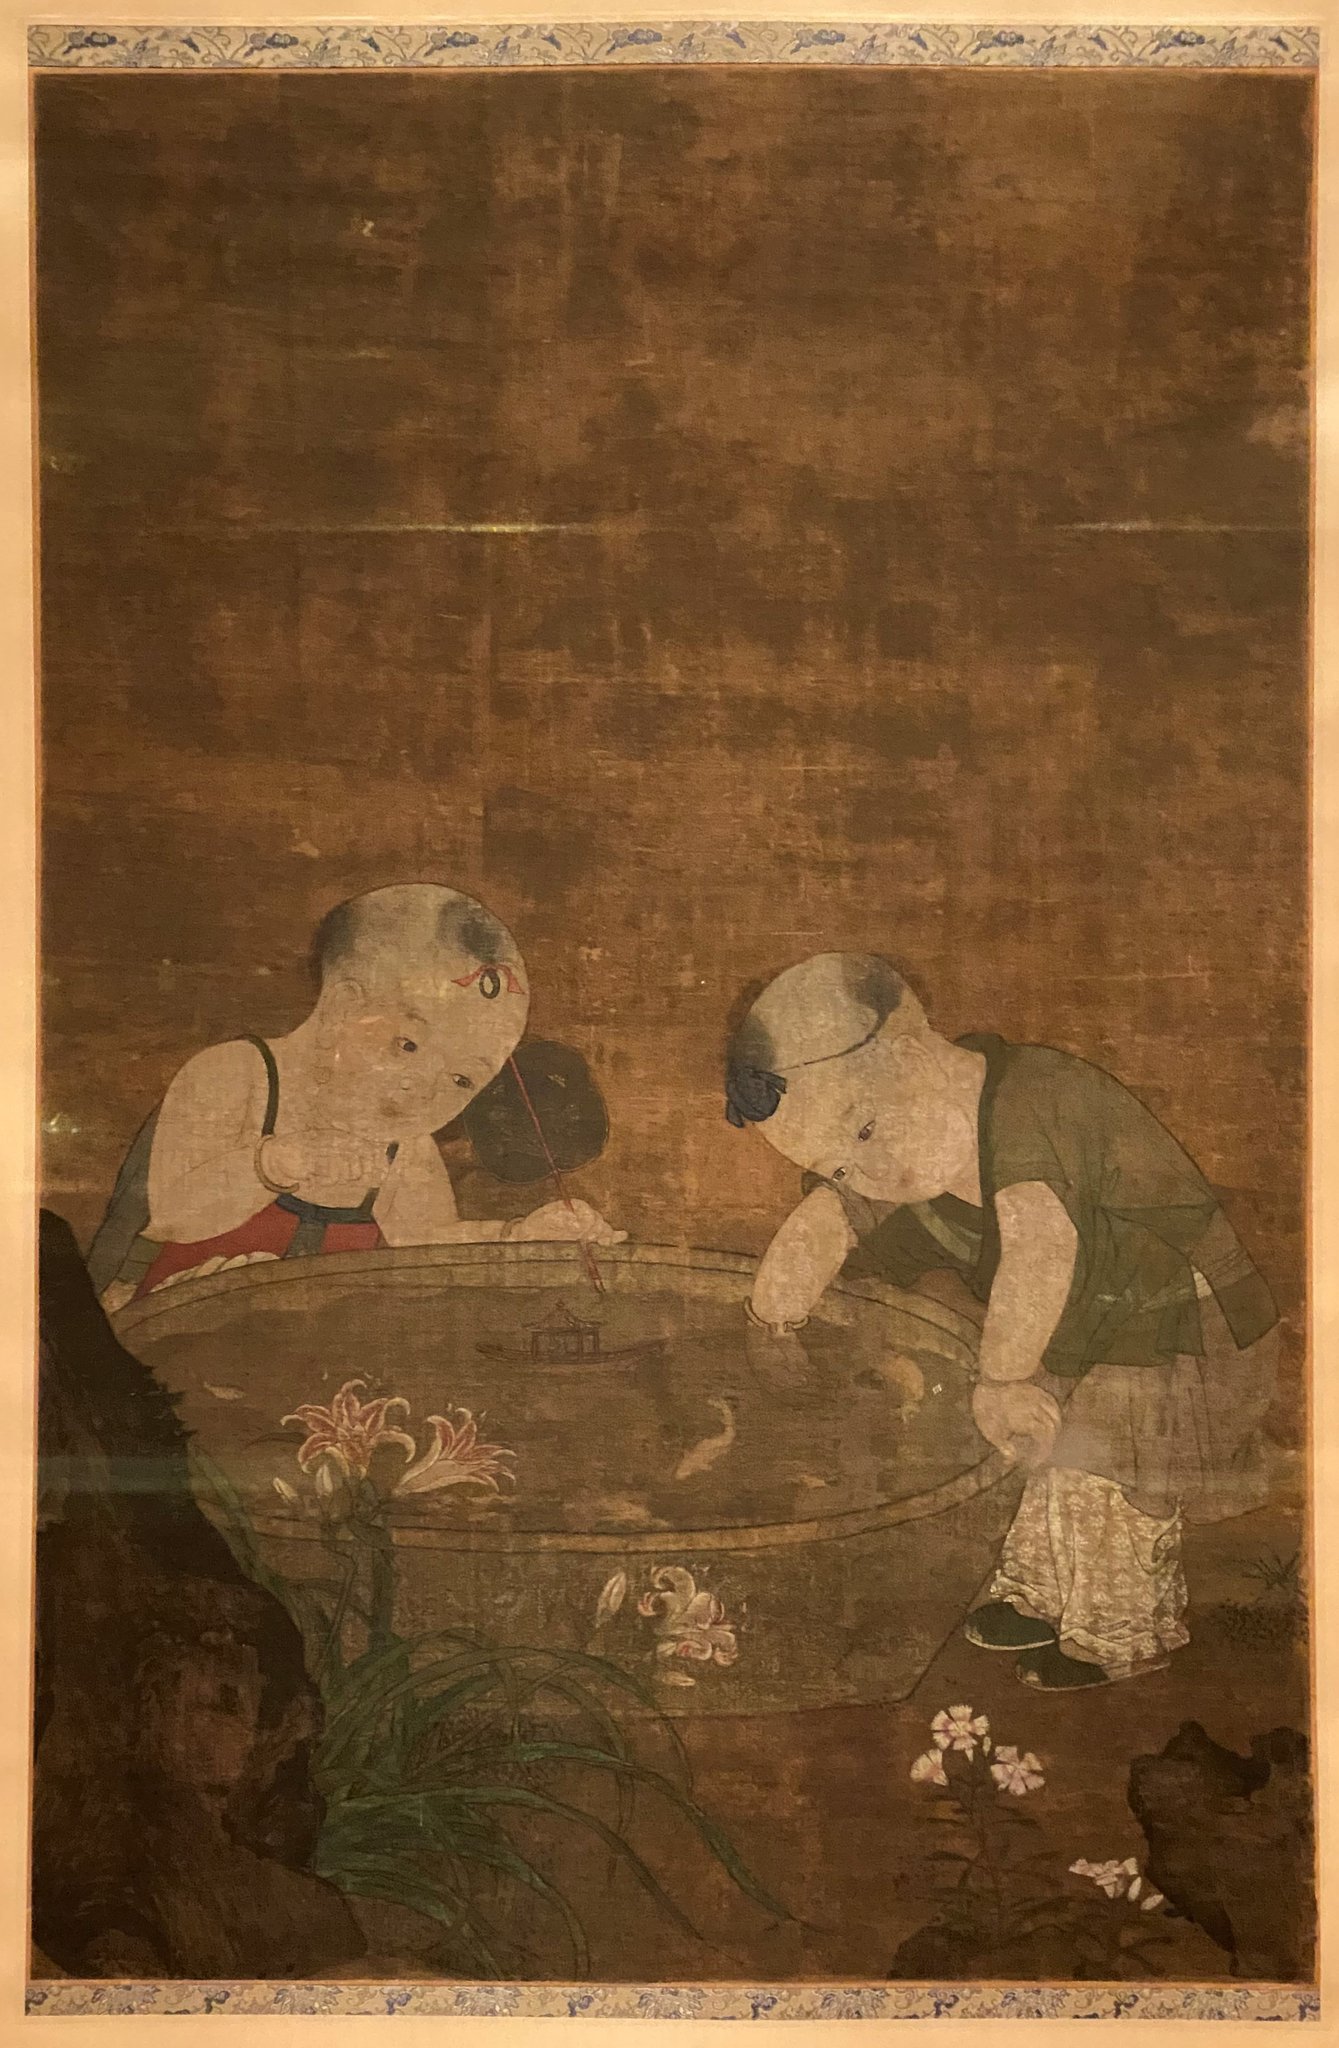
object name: hanging scroll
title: Children Playing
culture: chinese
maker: unidentified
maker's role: artist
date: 1501-1700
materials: ink, silk